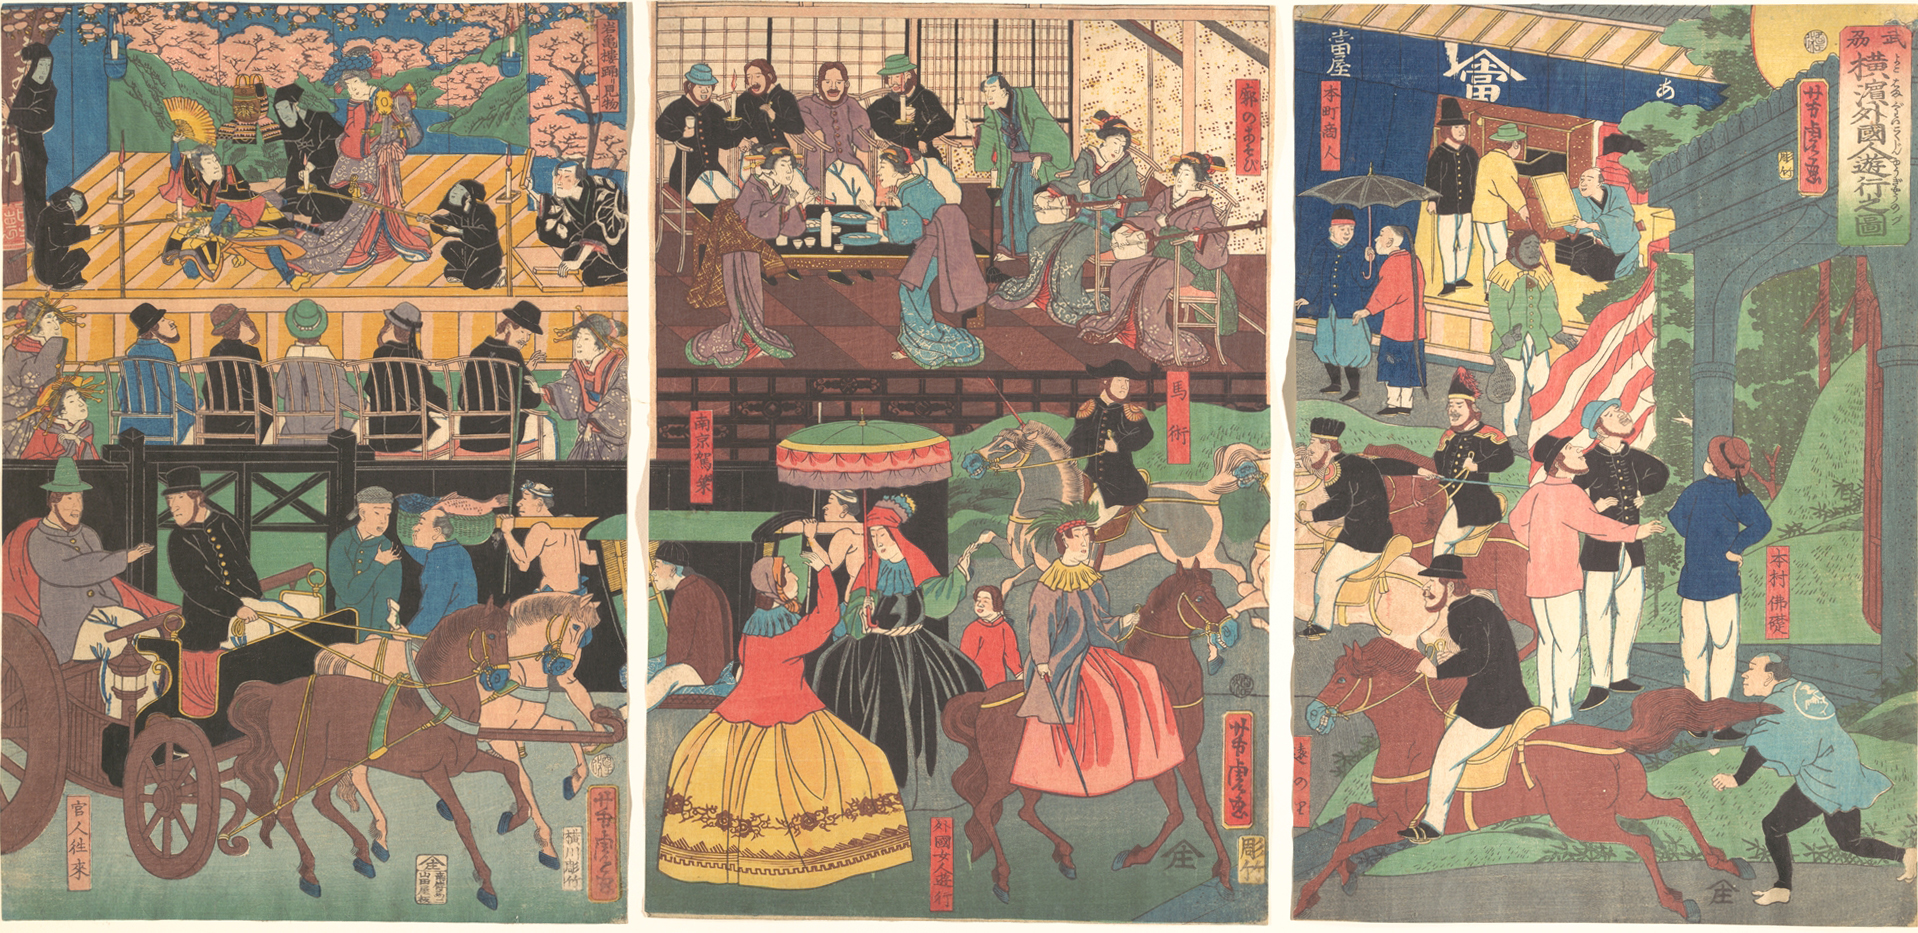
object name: print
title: A View of the Amusements of the Foreigners in Yokohama, Bushu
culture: japanese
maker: utagawa yoshitora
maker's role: artist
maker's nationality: japanese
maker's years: 1845-1880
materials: ink, paper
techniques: woodblock print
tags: men,women,concerts,horses,carriages